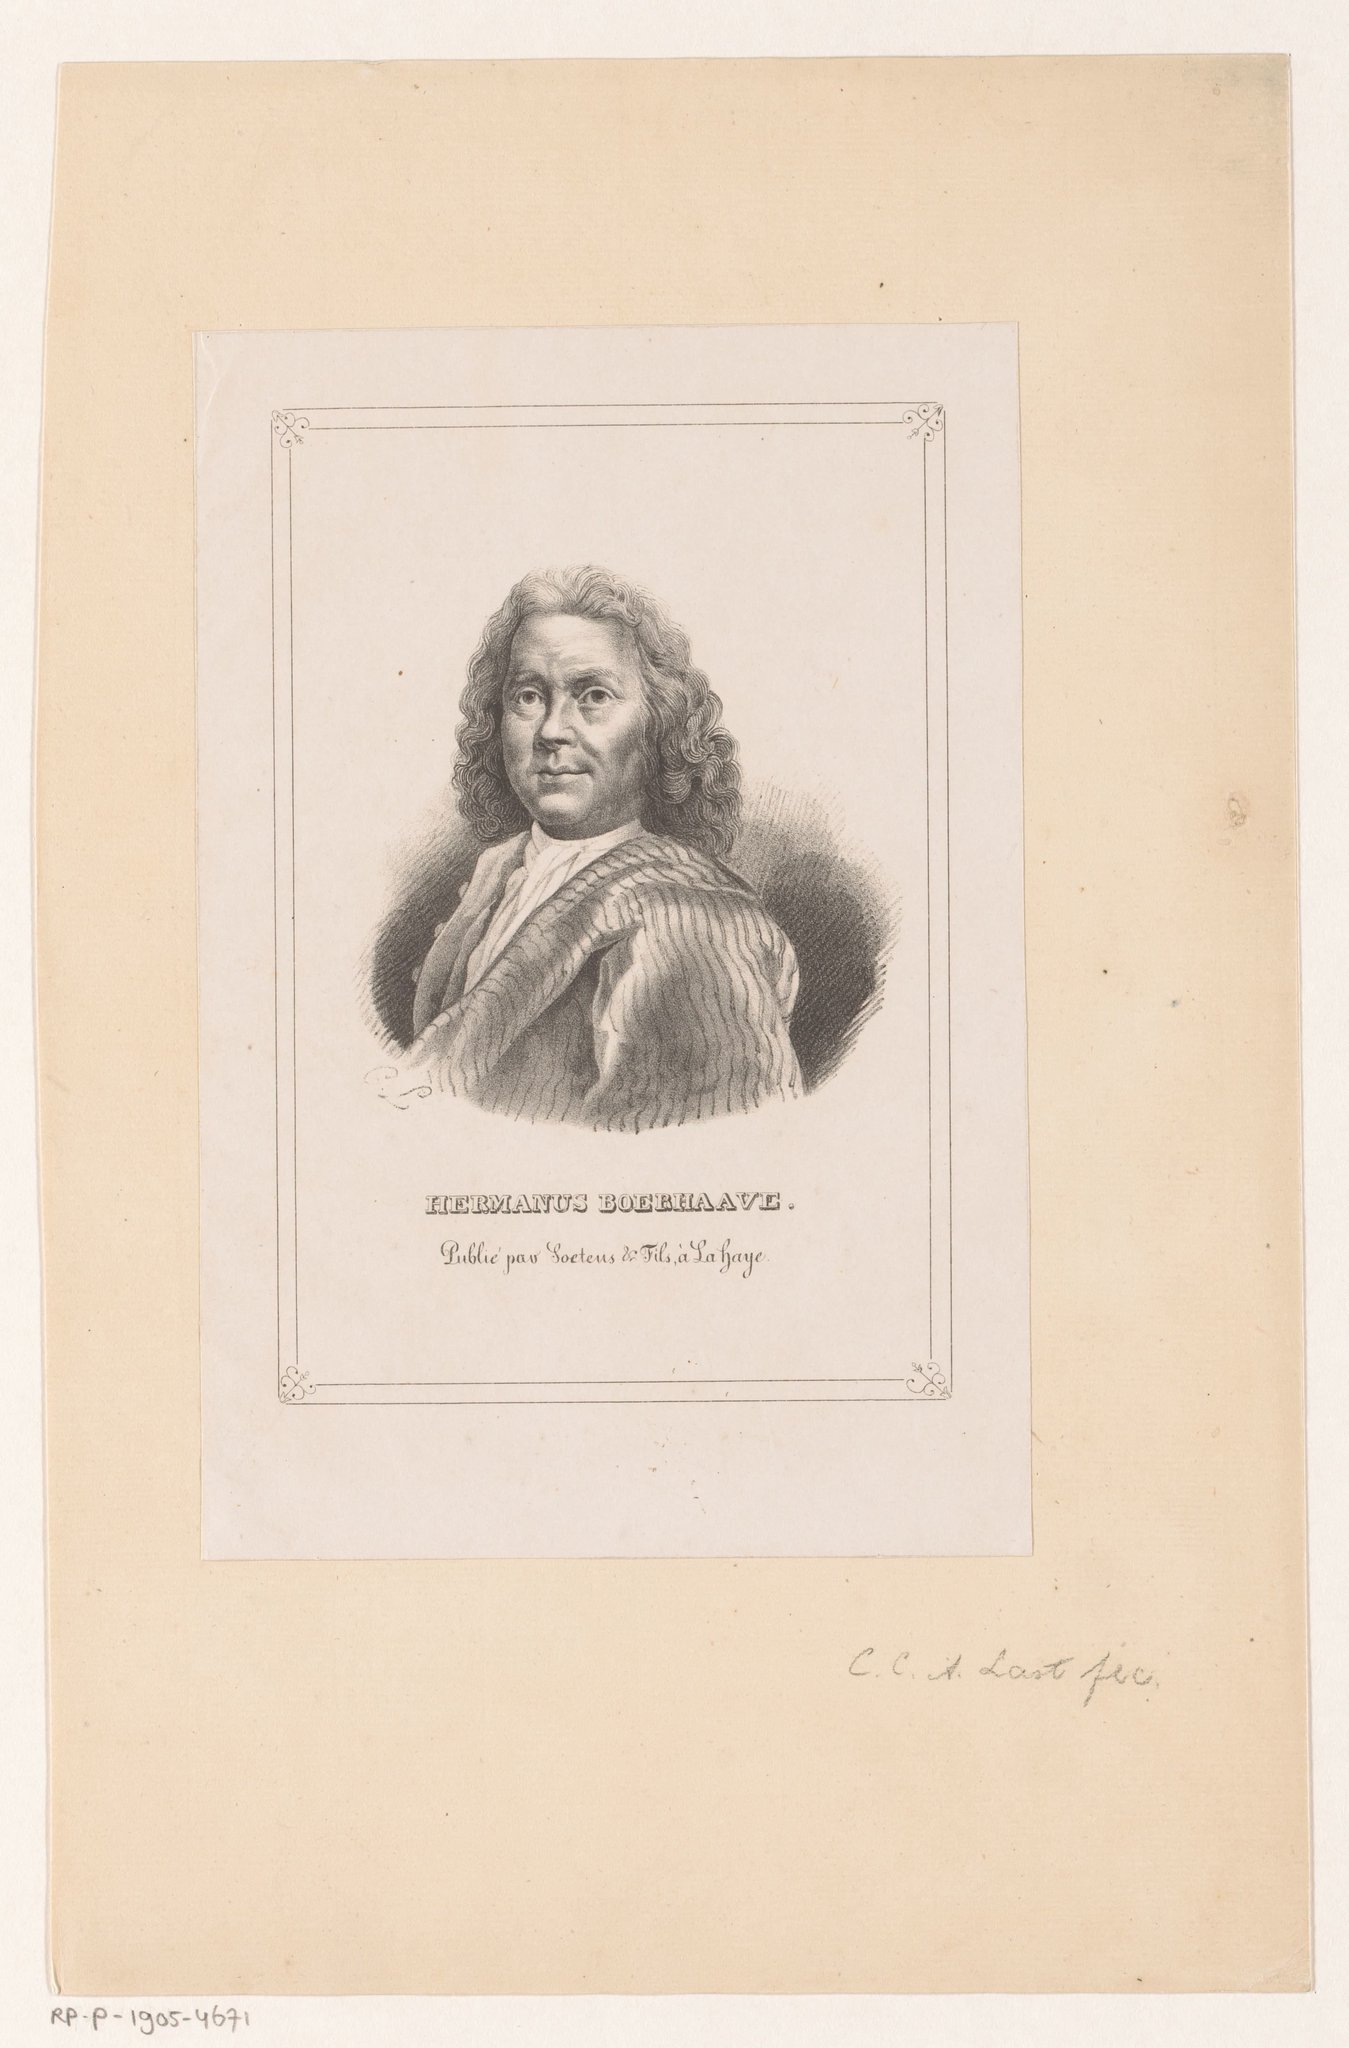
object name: print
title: Portret van Herman Boerhaave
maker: carel christiaan antony last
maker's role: print maker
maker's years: 1808-1876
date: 1837-1840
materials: paper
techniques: lithograph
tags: leiden, hermanus boerhaave, historical persons (+ (full) bust portrait)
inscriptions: collector's mark: Lugt 2228